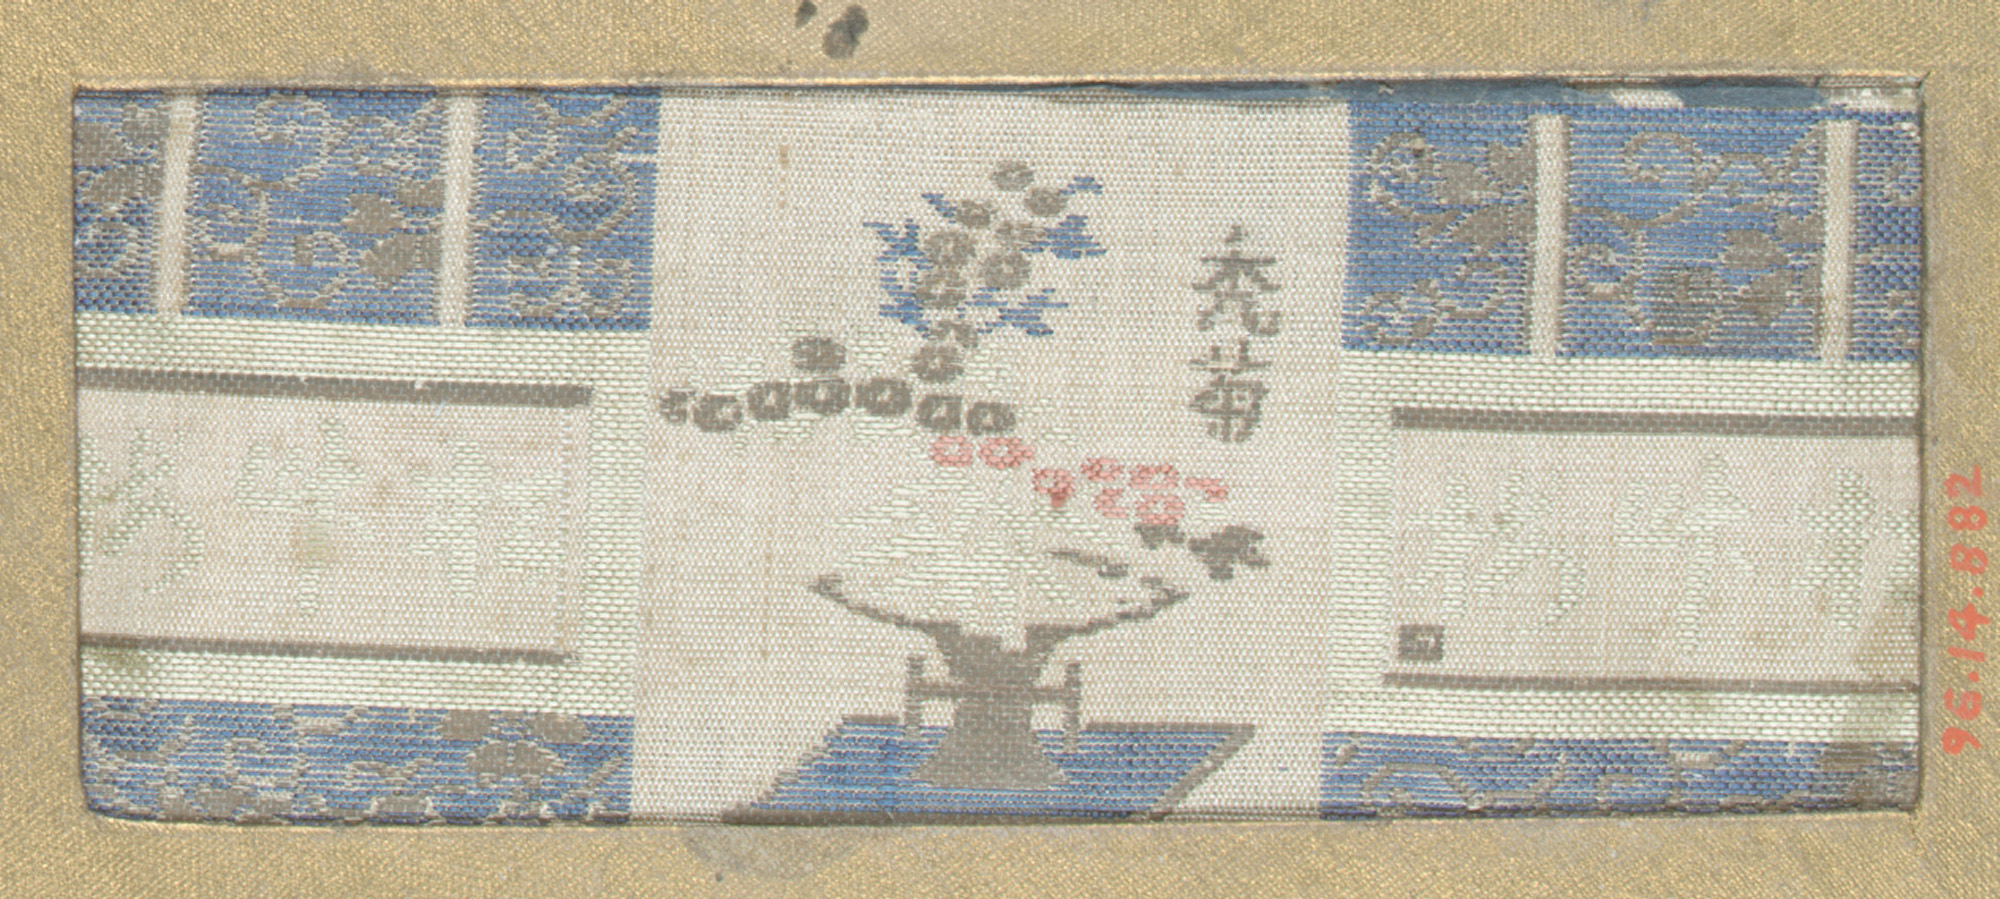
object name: piece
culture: japanese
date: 1701-1900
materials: silk